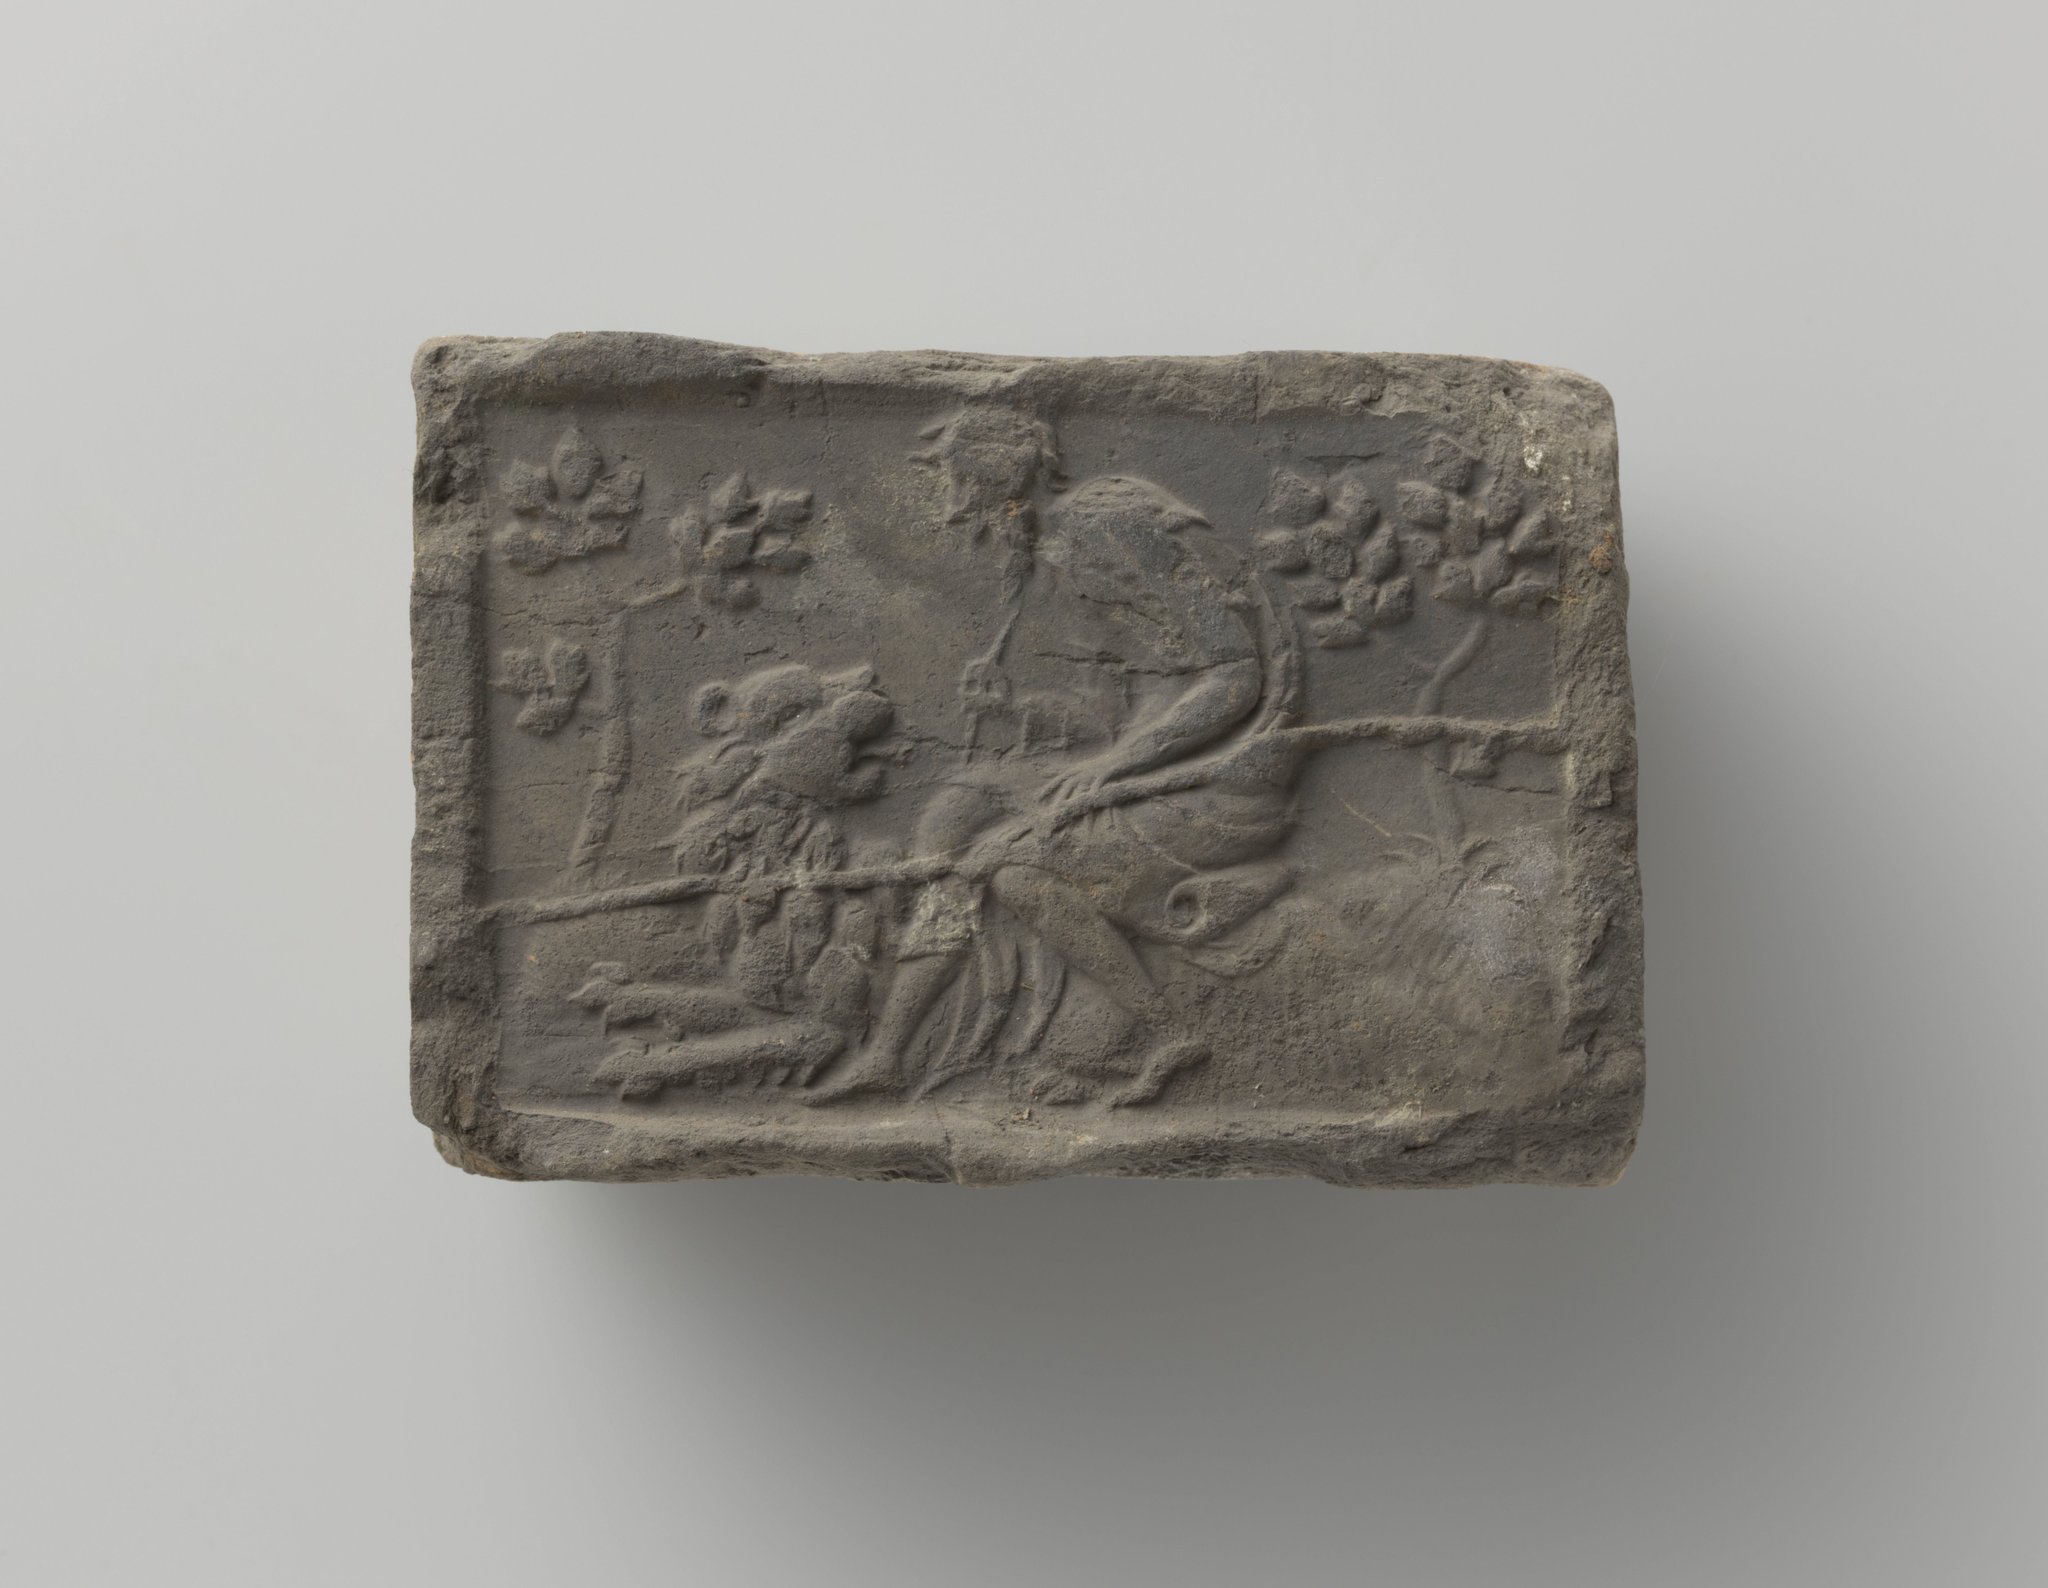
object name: architectural element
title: haardsteen met een voorstelling van de evangelist Marcus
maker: Anonymous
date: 1525-1575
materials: earthenware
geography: antwerp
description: Haardsteen met een voorstelling van de evangelist Marcus met een schrijfstift en een schriftrol. Aan zijn voeten een leeuw. Op de achtergrond een landschap met enkele bomen. Door de voorstelling loopt een horizontale lijn.